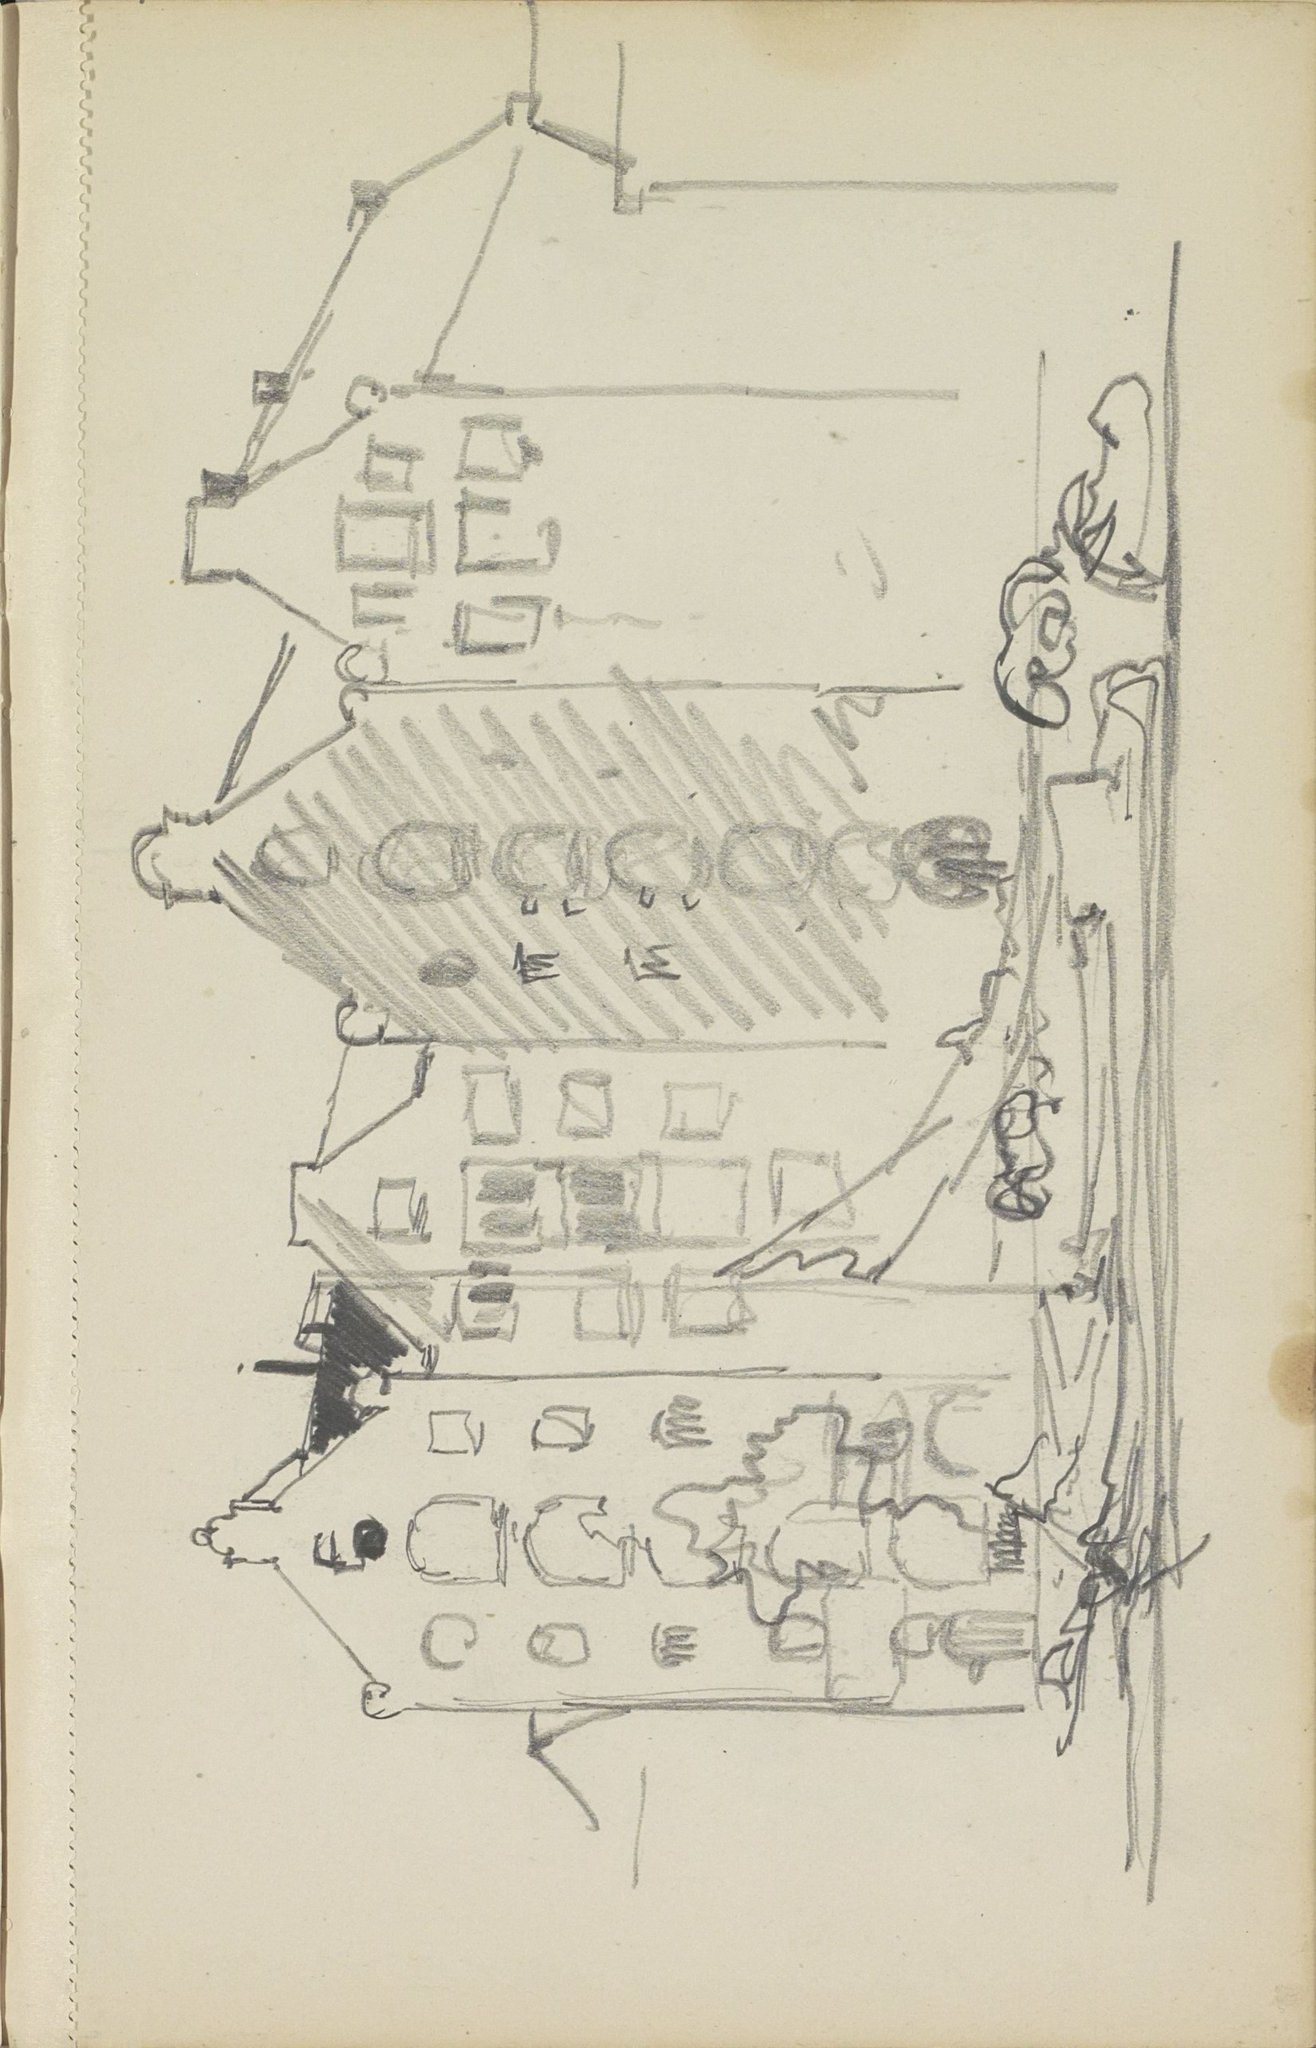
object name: sketchbook leaf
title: Rijtjeshuizen aan een gracht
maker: cornelis vreedenburgh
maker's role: draughtsman, print maker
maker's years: 1880-1946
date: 1890-1946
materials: paper, pencil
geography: amsterdam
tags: canals, waters (in city), the usual house or row of houses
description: Blad 25 recto uit een schetsboek met 56 bladen.